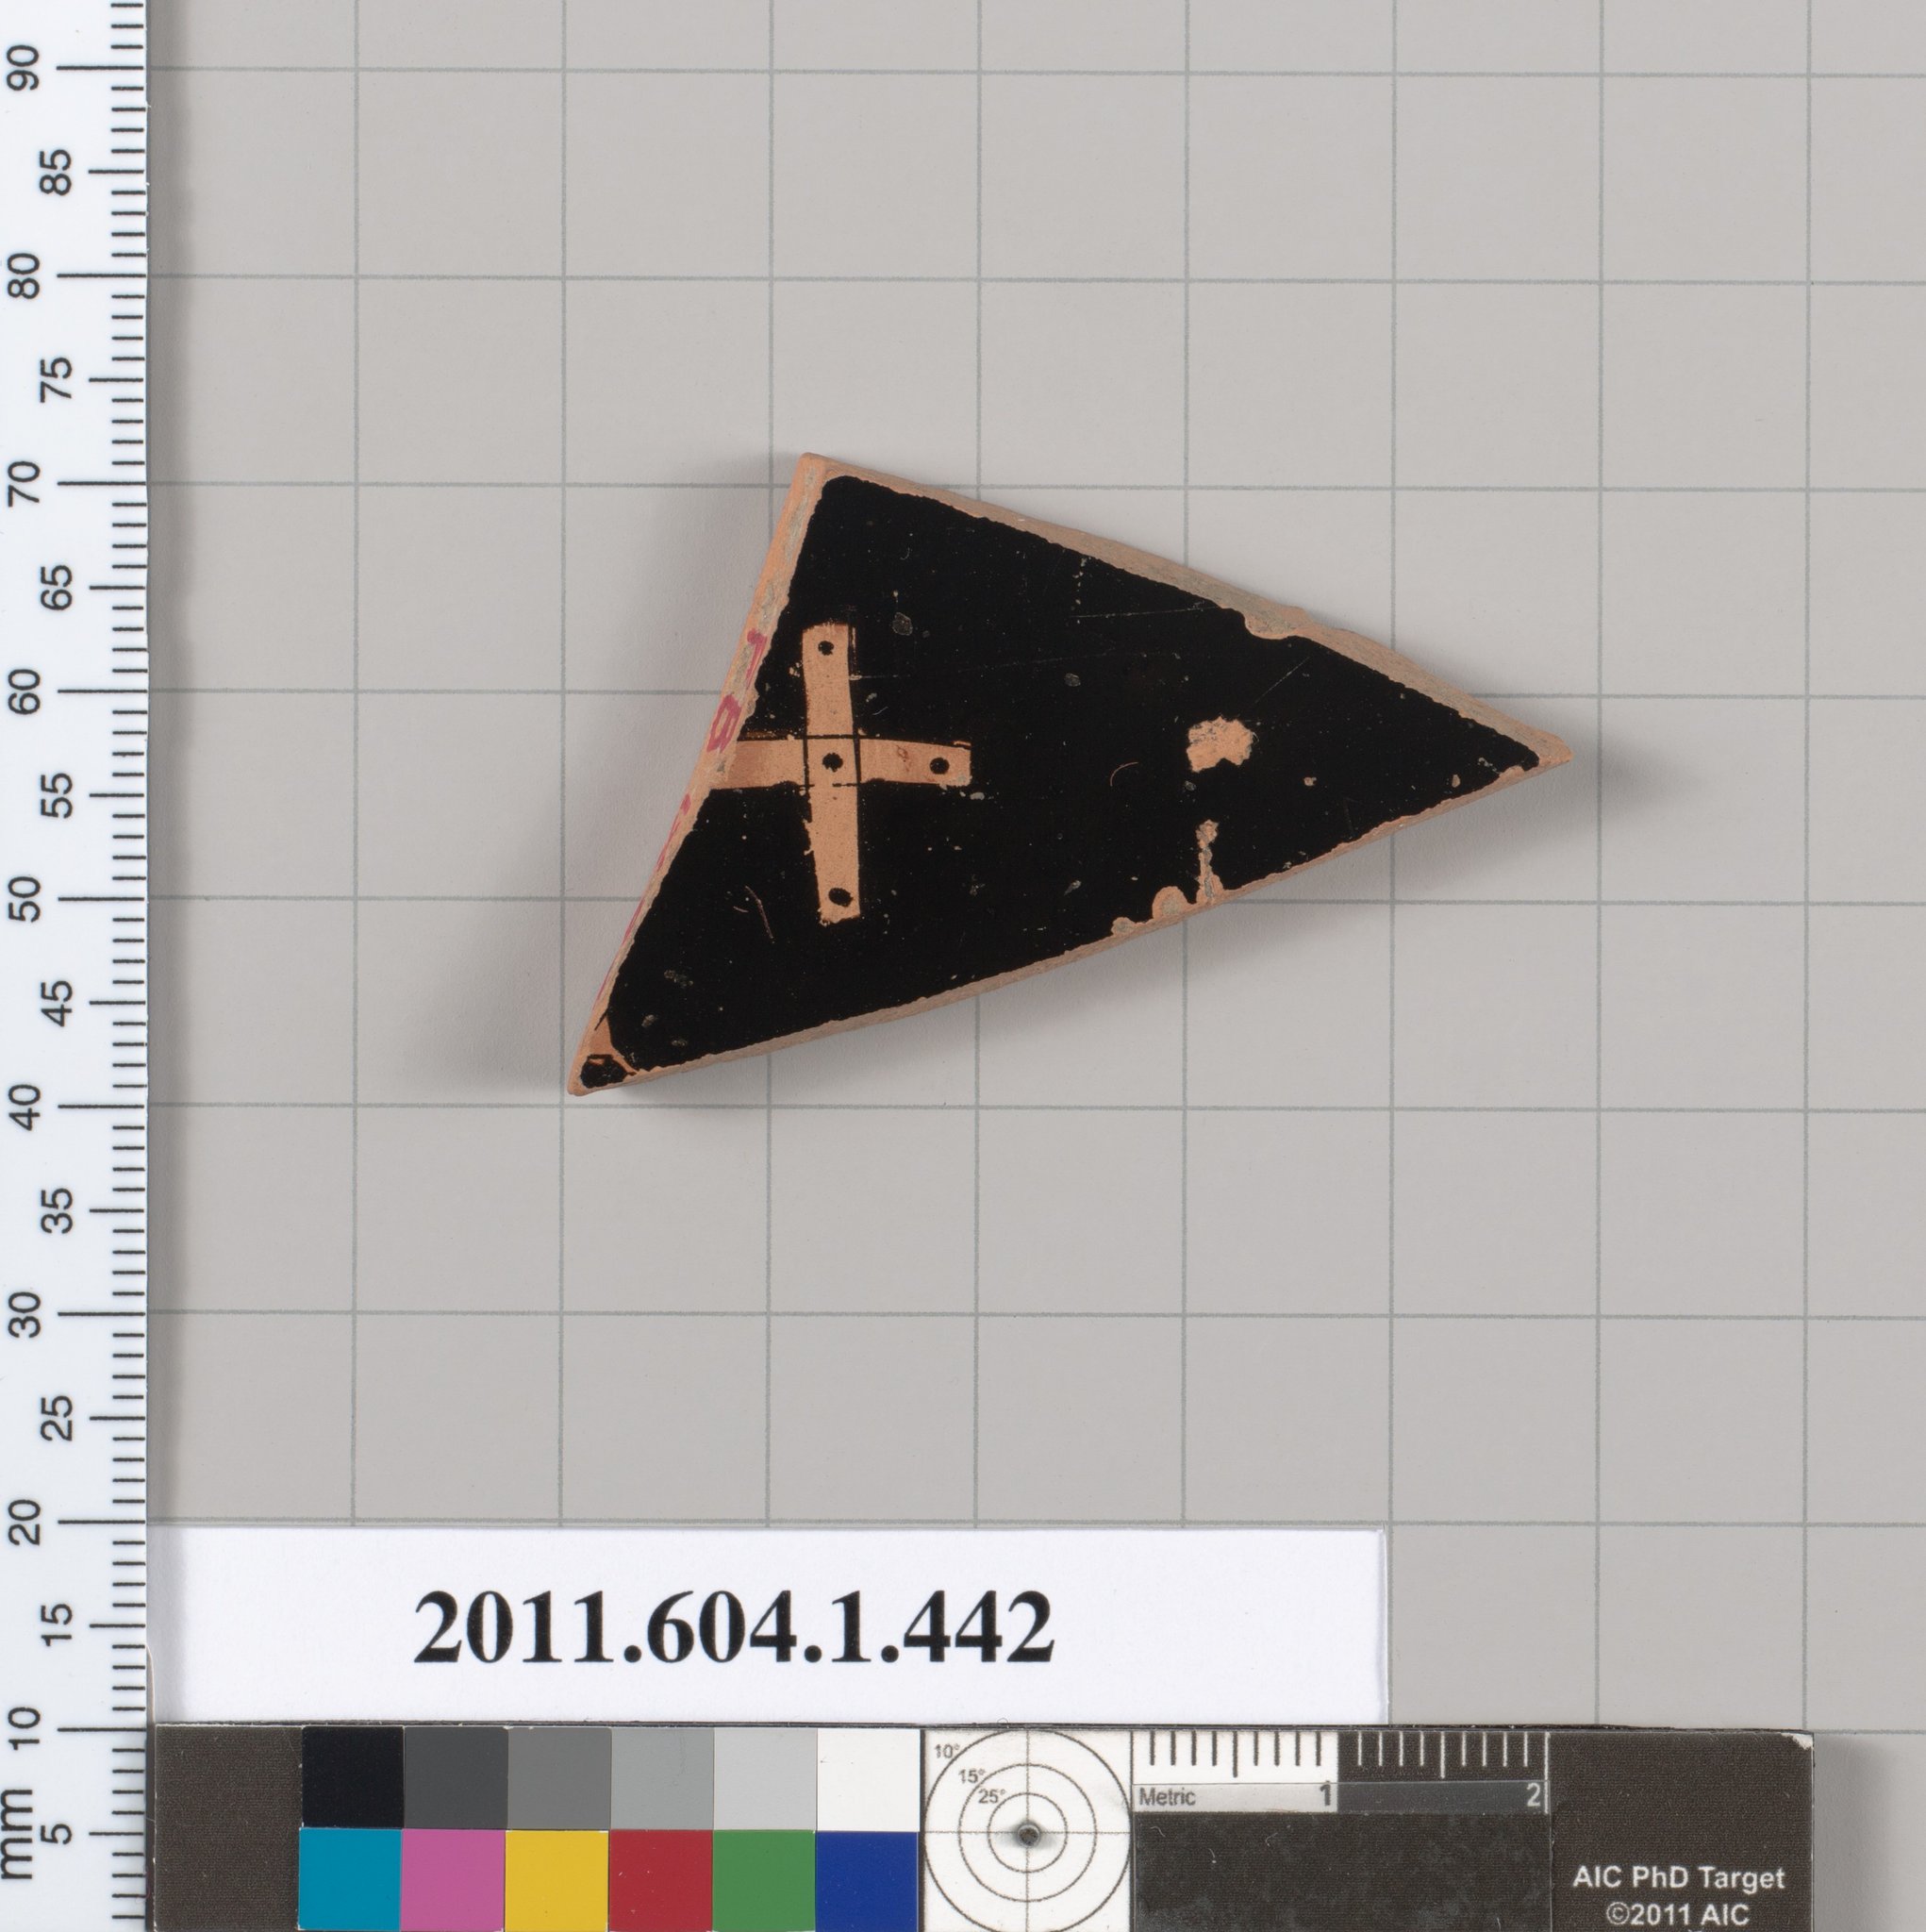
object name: kylix fragment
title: Terracotta fragment of a kylix (drinking cup)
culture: greek, attic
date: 401-450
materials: terracotta